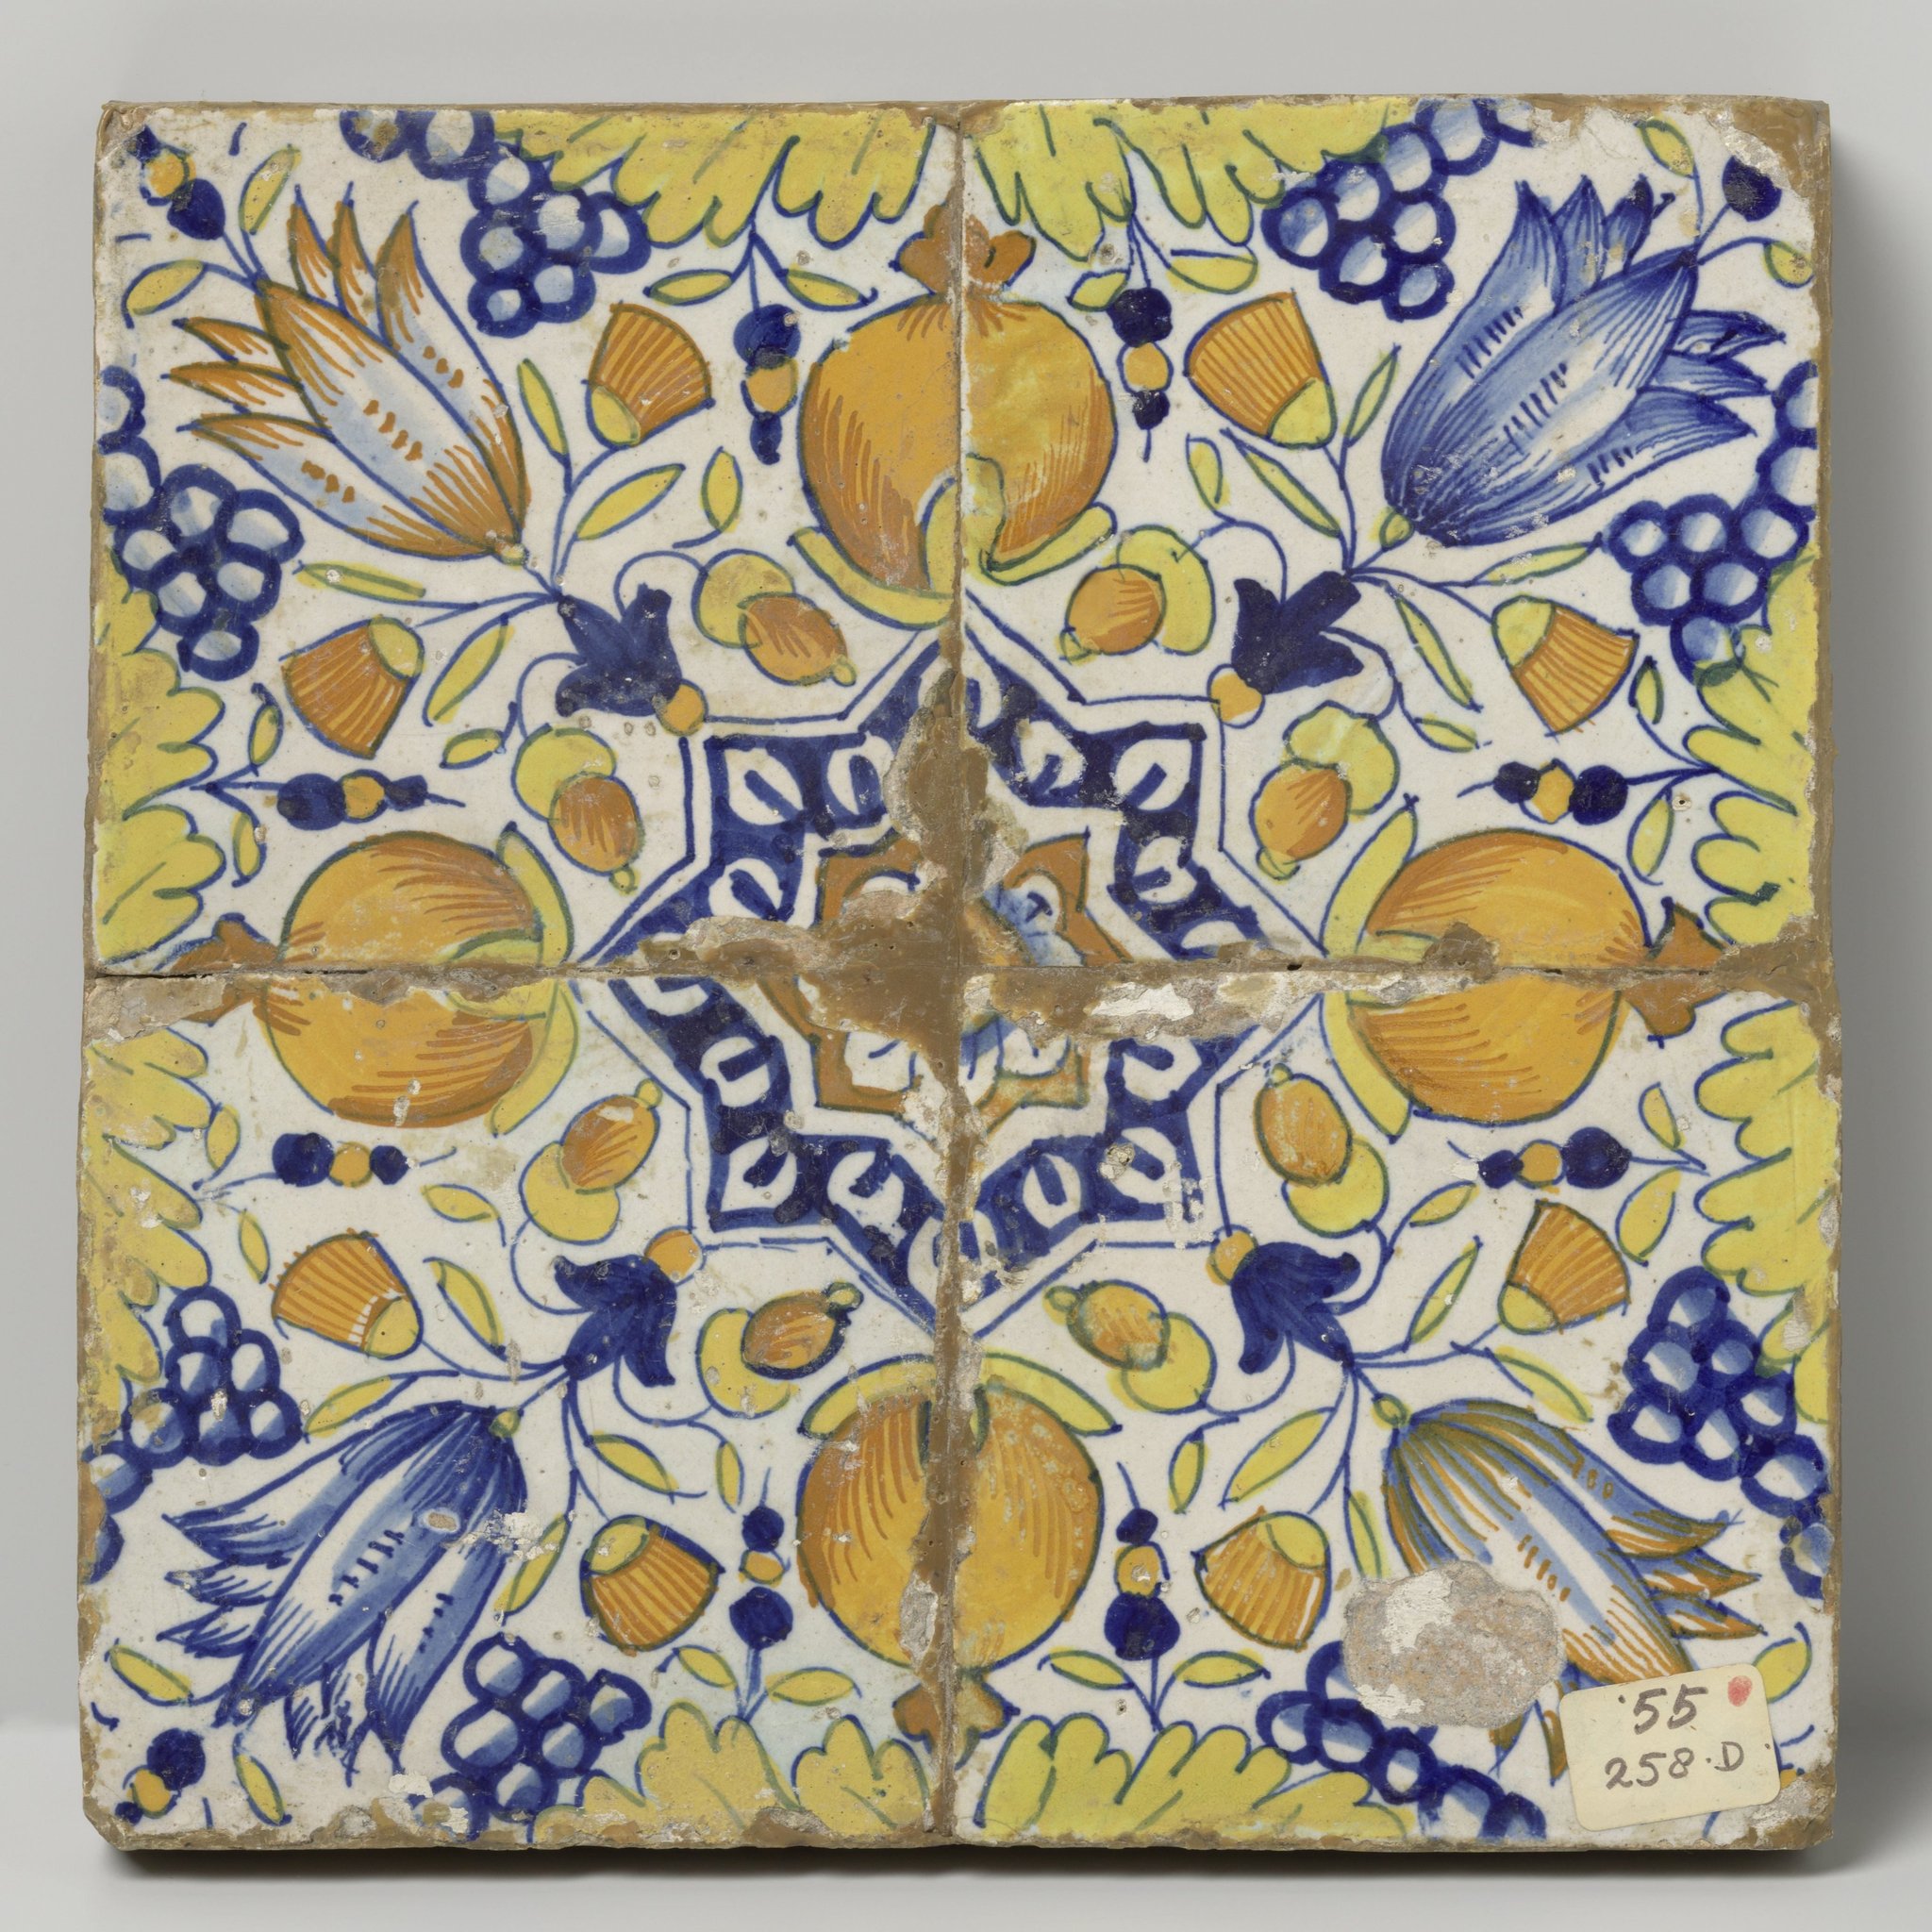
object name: tile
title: Veld van vier tegels (2x2) met een veelkleurig patroon in blauw, geel, oranje en paars van granaatappels, druiventrossen en tulpen rond een ster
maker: Anonymous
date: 1600-1625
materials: earthenware, glaze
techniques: maiolica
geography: netherlands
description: Veld van vier tegels (2 x 2) met een veelkleurig (blauw, geel, oranje en paars) patroon met granaatappels, druiventrossen en tulpen rond een ster.